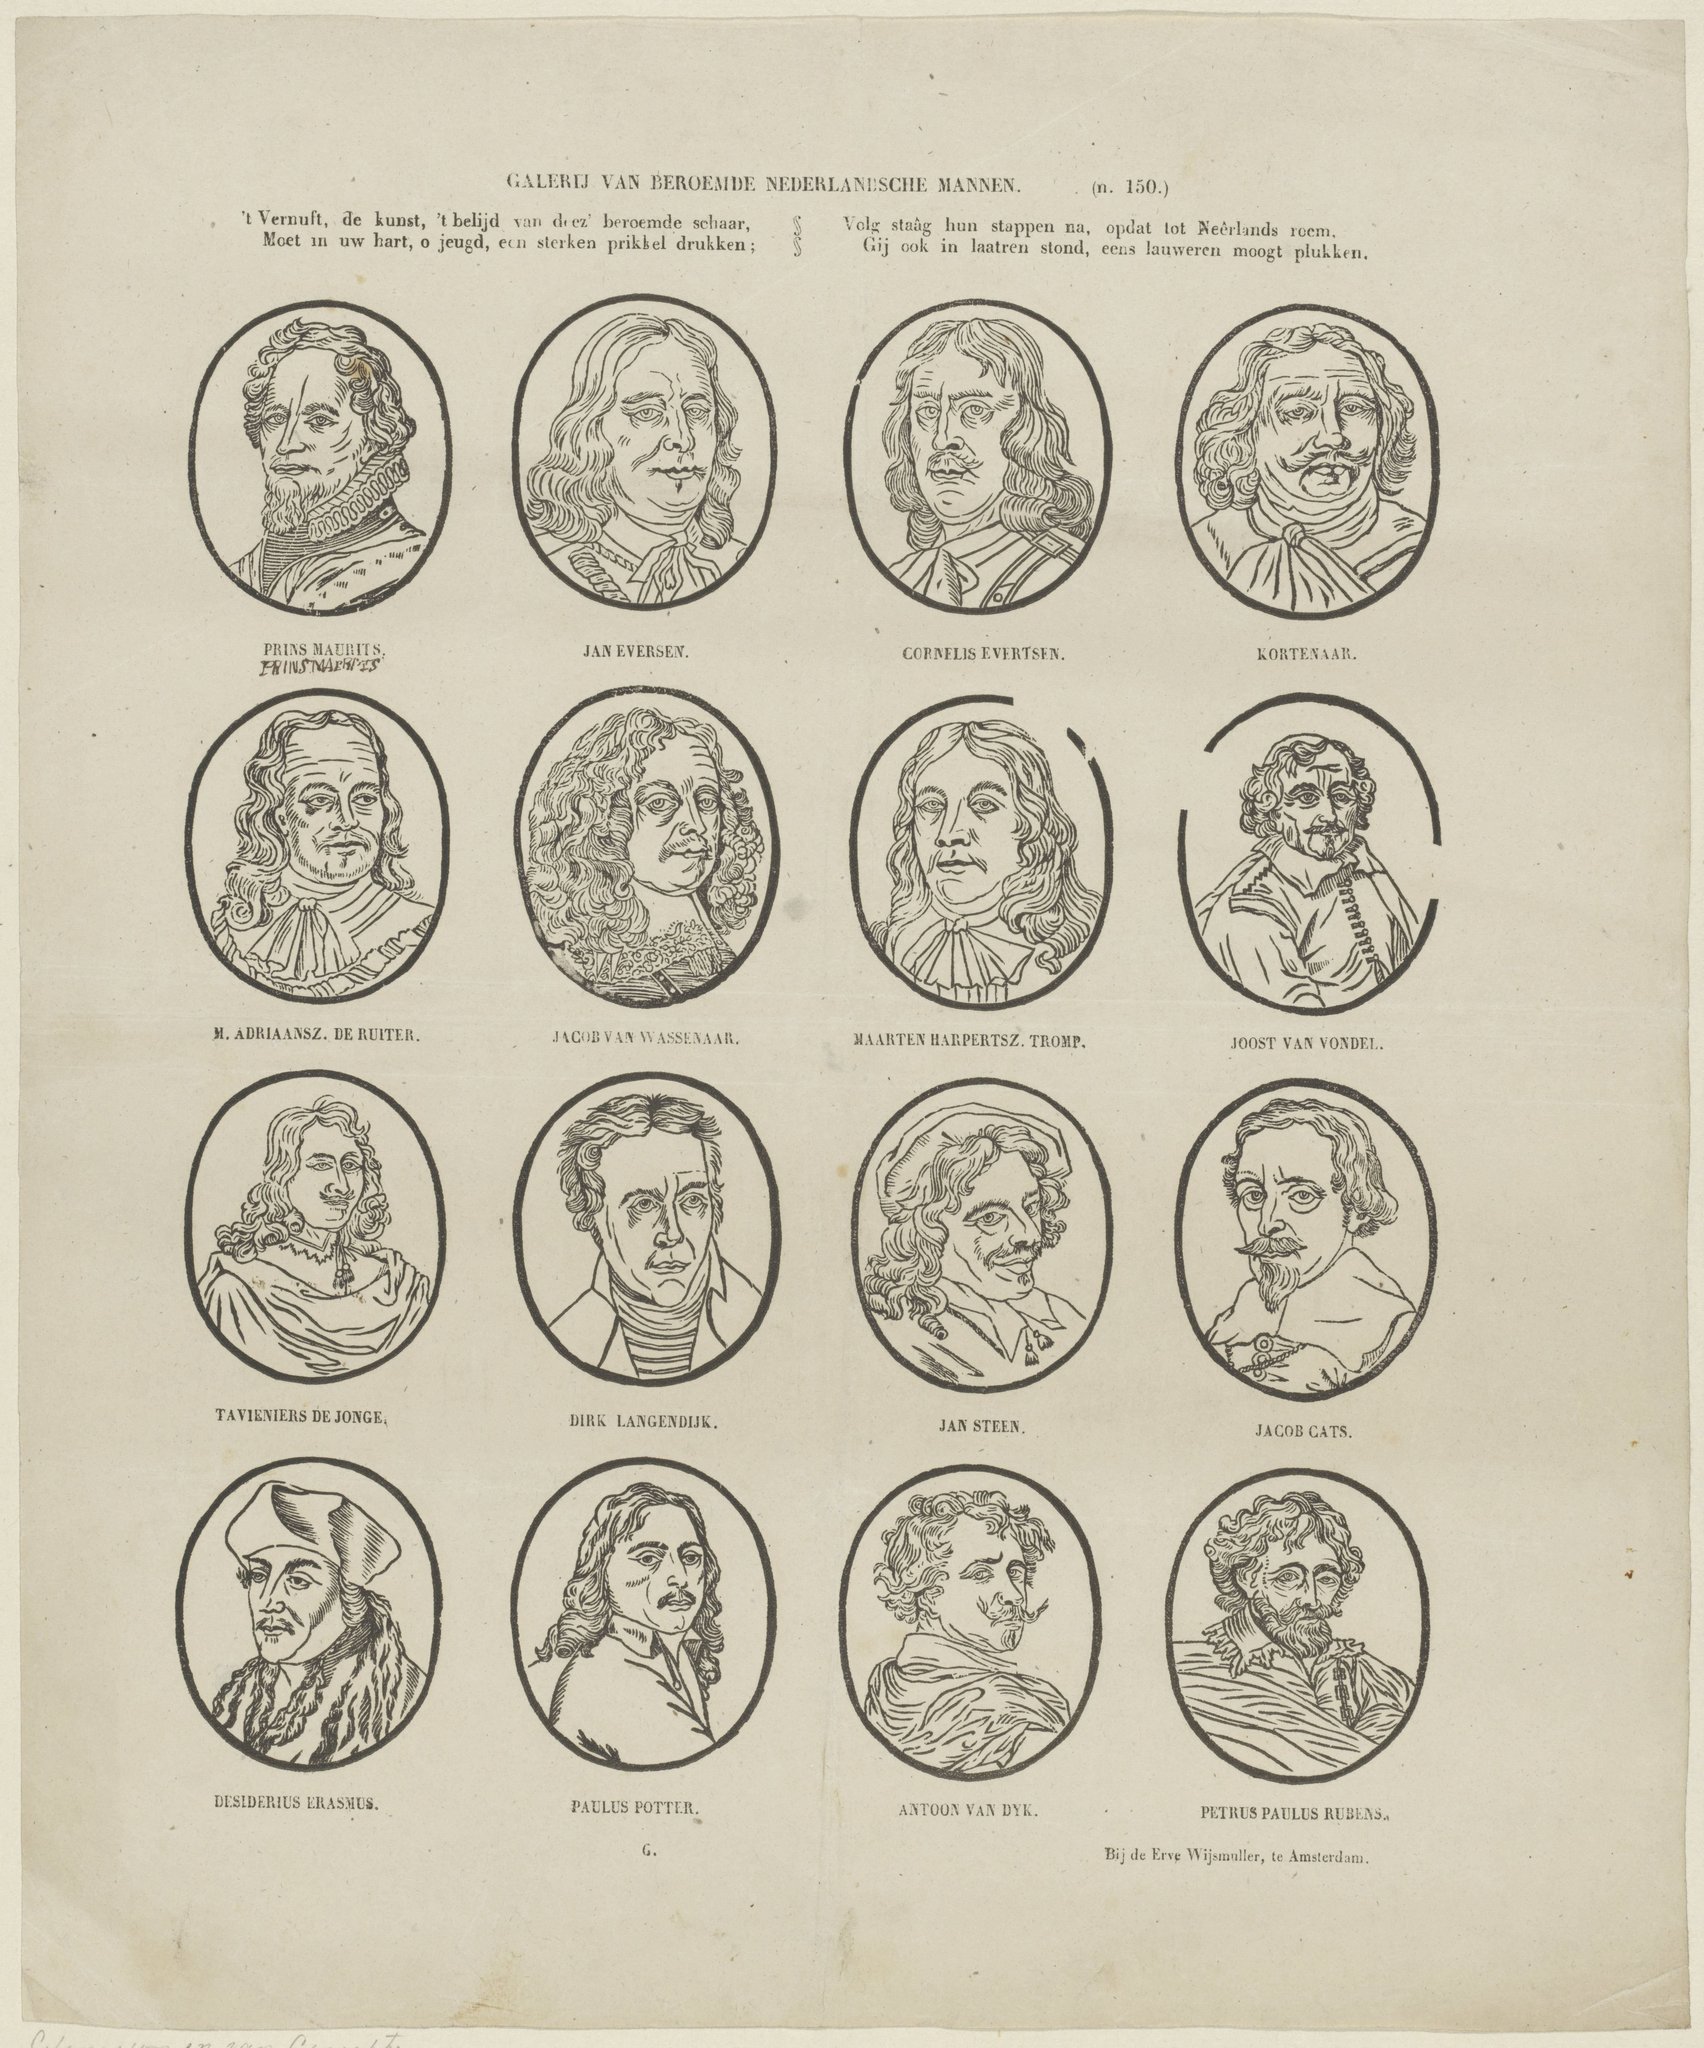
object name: popular print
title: Galerij van beroemde Nederlandsche mannen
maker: Anonymous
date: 1828-1913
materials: paper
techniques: letterpress printing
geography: amsterdam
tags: rotterdam, dirk langendijk, enkhuizen, amsterdam, paulus potter, cornelis evertsen (1628-1679), leiden, jan havicksz. steen, desiderius erasmus, flushing, michiel adriaenszoon de ruyter, jacob baron van wassenaer heer van obdam, maurice (prince of orange), the hague, jacob cats (1577-1660), peter paul rubens, antwerp, london, painter, print maker, draughtsman, anthony van dyck, cologne, joost van den vondel, brielle, maarten harpertszoon tromp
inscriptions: collector's mark: Lugt 2760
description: Blad met 16 ovale portretten van beroemde Nederlandse mannen, onder wie Prins Maurits, Joost van den Vondel, Jan Steen, Erasmus en Peter Paul Rubens. Onder de titel een vierregelig vers in twee kolommen, onder elke afbeelding een onderschrift. Genummerd rechtsboven: (n. 150).